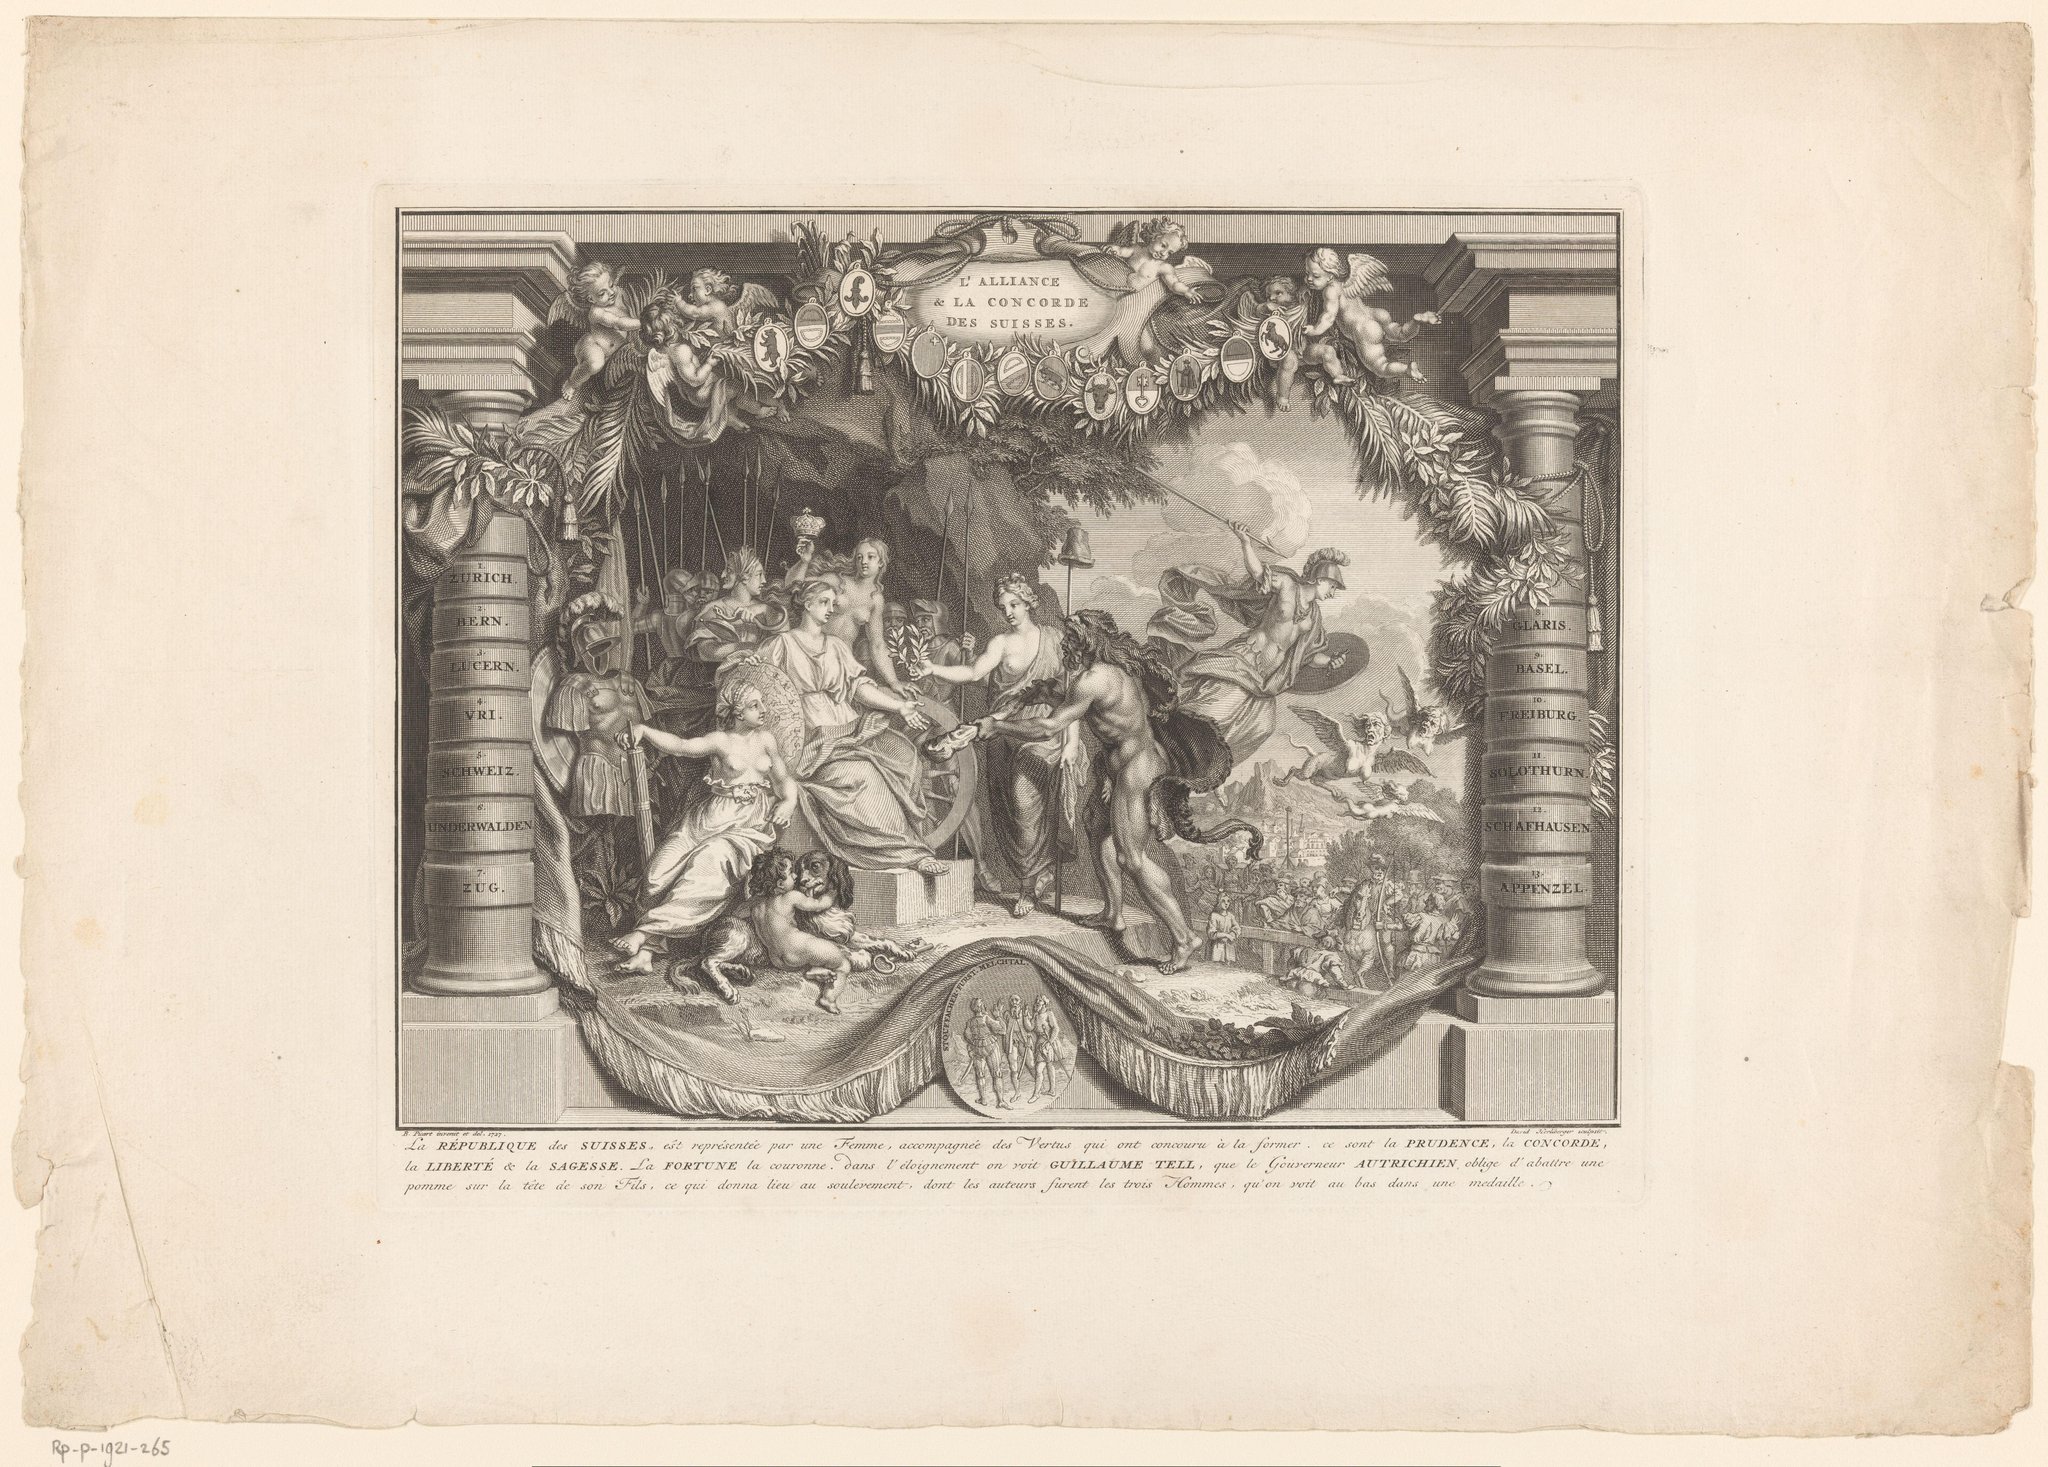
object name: print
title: Allegorische voorstelling van de Zwitserse Confederatie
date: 1727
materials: paper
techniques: engraving, etching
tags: william tell, (story of) hercules (heracles), personifications of countries, nations, states, districts, etc., wisdom, 'sapientia' ~ one of the seven gifts of the soul, key, fortuna as roman personification, luck, fortune, lot; 'fato', 'fortuna', 'fortuna aurea', 'fortuna buona', 'fortuna pacifica overo clemente', 'sorte' (ripa), harpy (fabulous bird); 'arpie' (ripa), freedom, liberty; 'libertà' (ripa), ornament ~ festoon, garland, cupids: 'amores', 'amoretti', 'putti', armorial bearing, heraldry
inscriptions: collector's mark: Lugt 2233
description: Hercules overhandigt zijn knots aan Zwitserland. Zij wordt vergezeld door de vijf vrouwelijke personificaties van Vrijheid, Voorzichtigheid, Eendracht, Wijsheid en Fortuna. Op de achtergrond schiet Willem Tell, onder toeziend oog van de Oostenrijkse gouverneur, de appel van zijn zoons hoofd. De voorstelling is omlijst door zuilen waarop de steden die Zwitserland vormen vermeld staan en door putti gedragen guirlandes. Met onderschrift in het Frans.